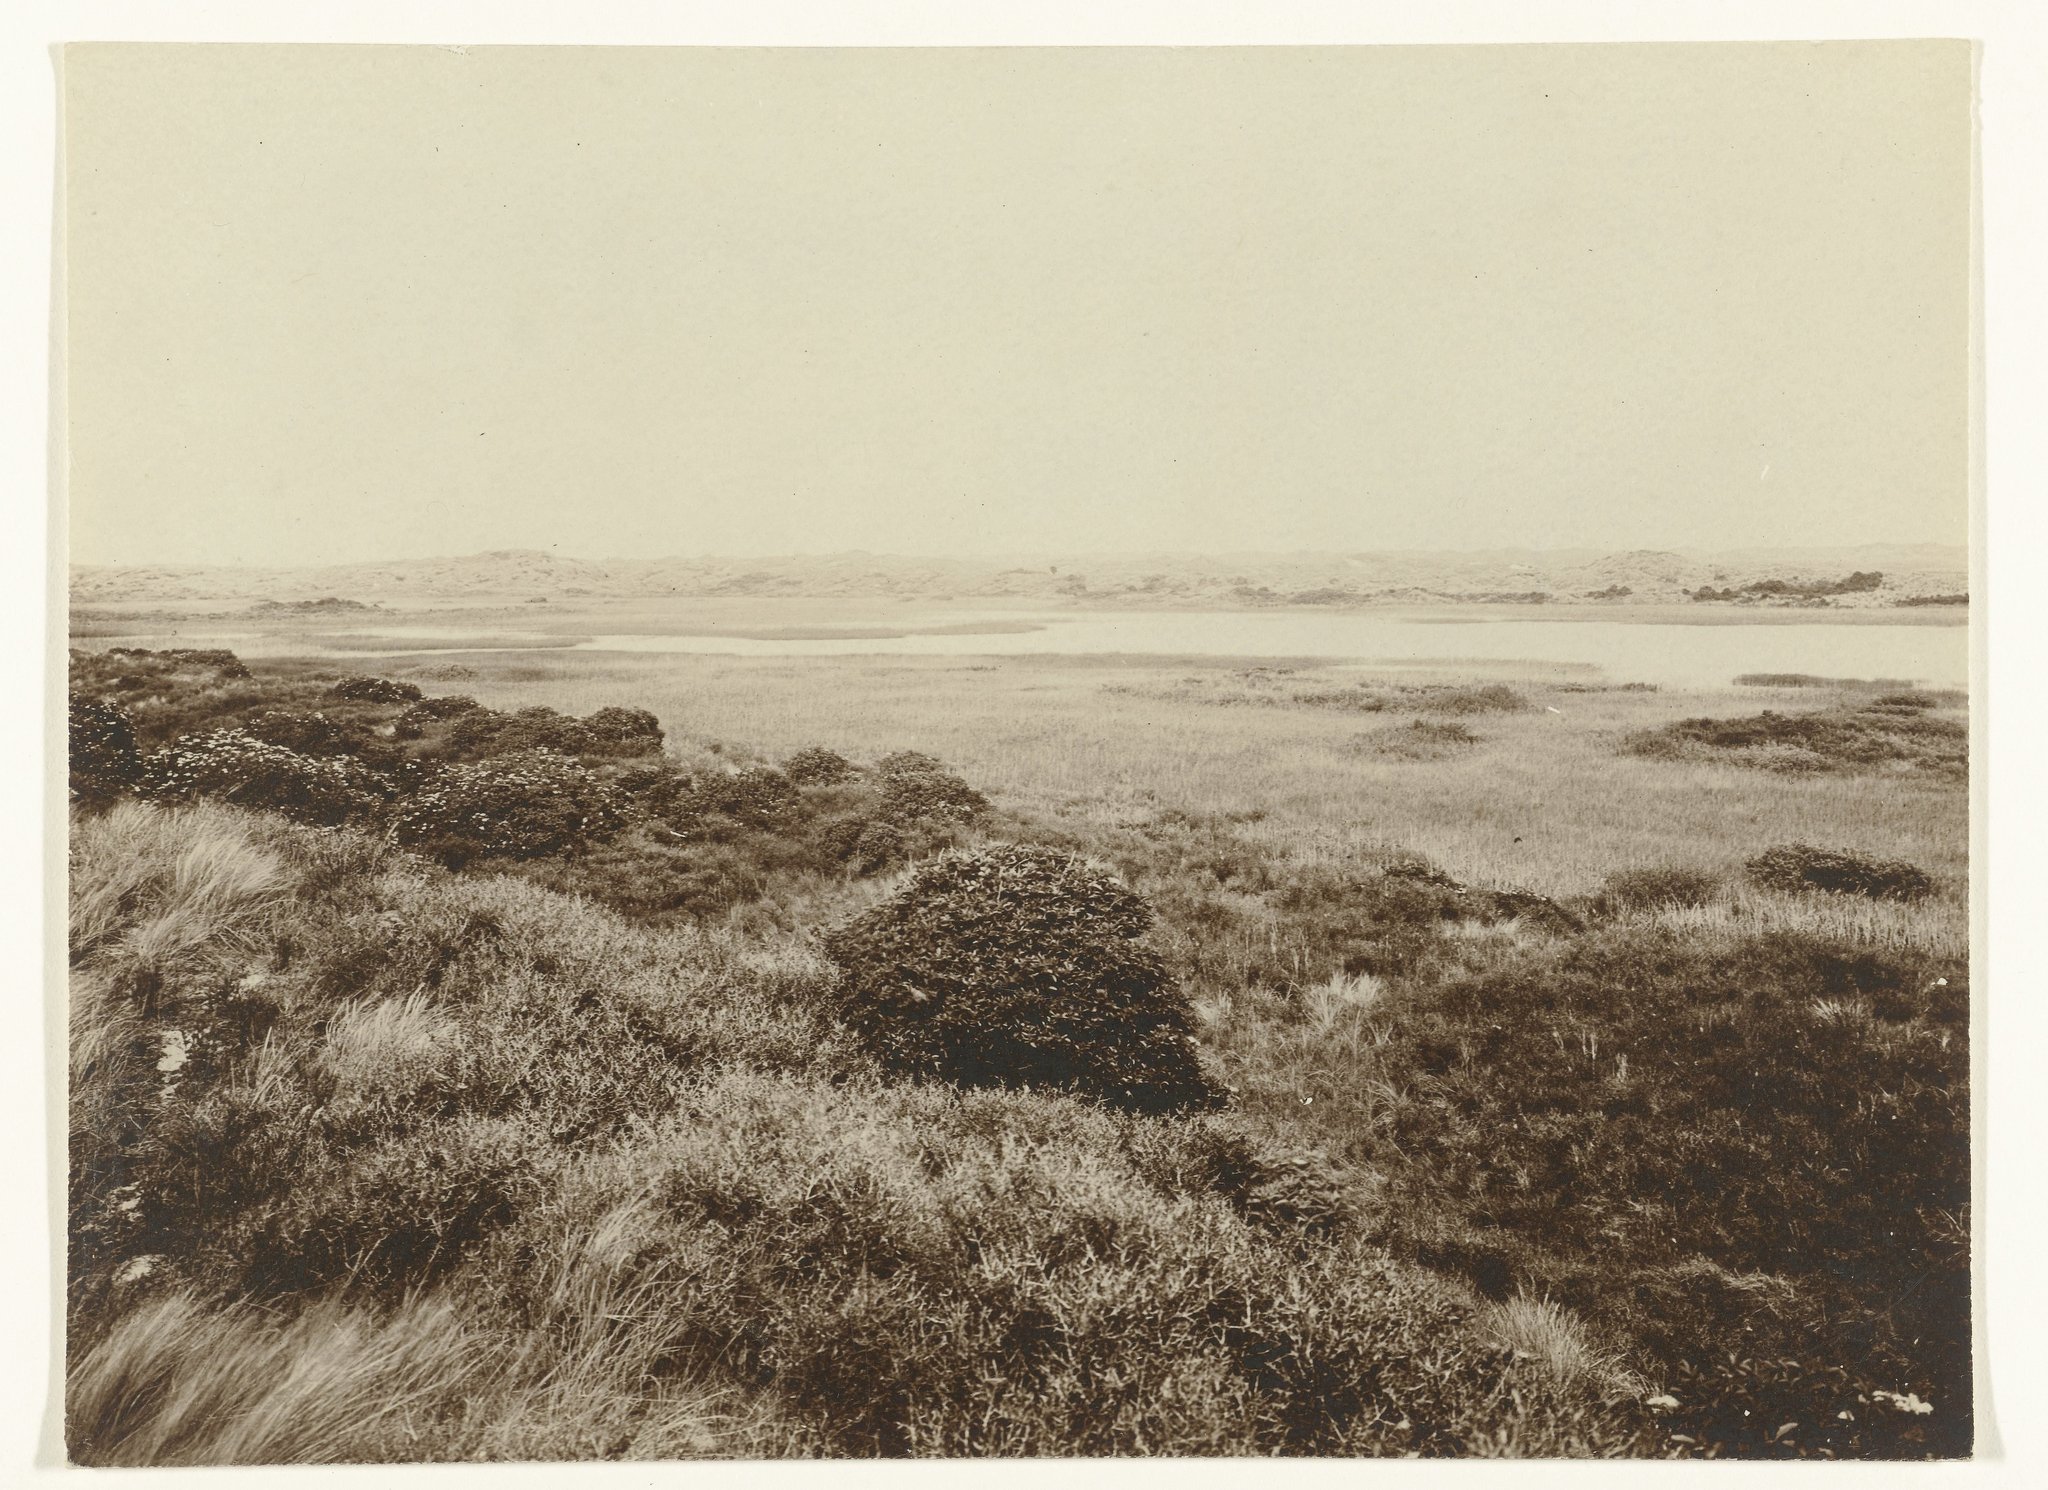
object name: photograph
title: Duinlandschap De Muy, Texel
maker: richard tepe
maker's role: fotograaf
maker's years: 1864-1952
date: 1900-1930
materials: paper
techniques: gelatin silver print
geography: netherlands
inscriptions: annotation: ‘In de Muy duinen op Tessel’